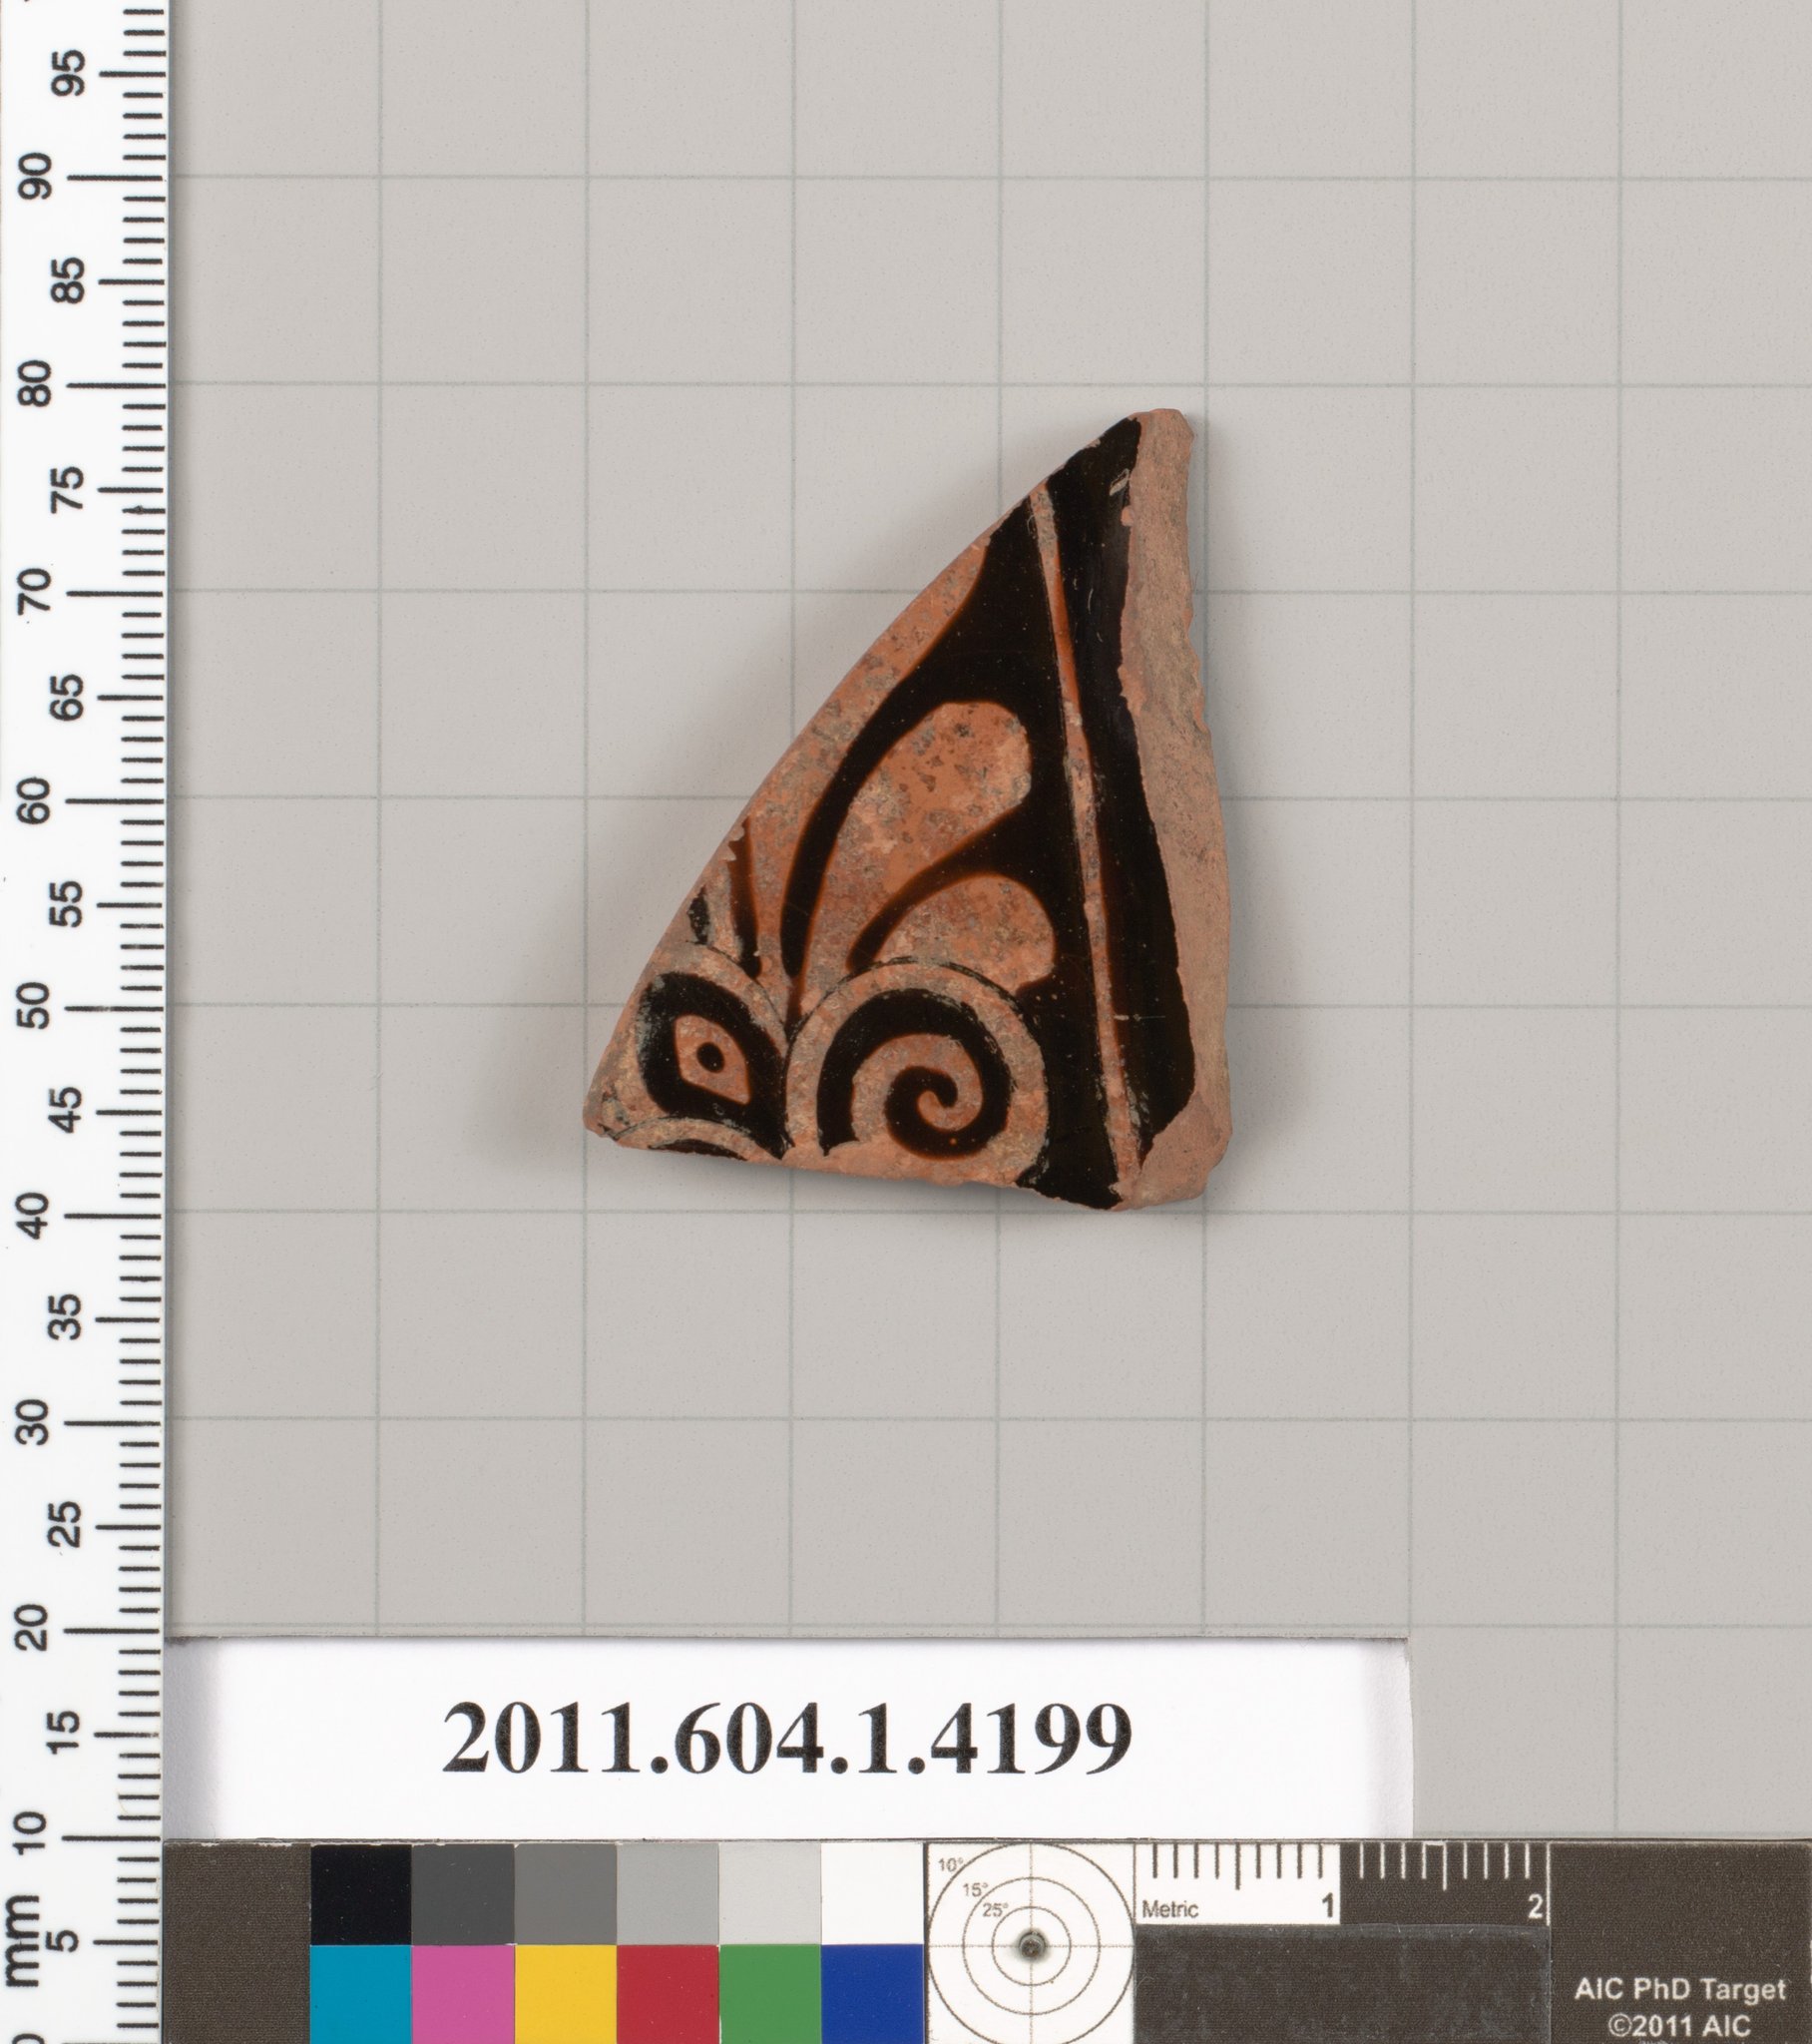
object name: kylix fragment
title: Terracotta fragment of a kylix (drinking cup)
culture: greek, attic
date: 500-476 BCE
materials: terracotta